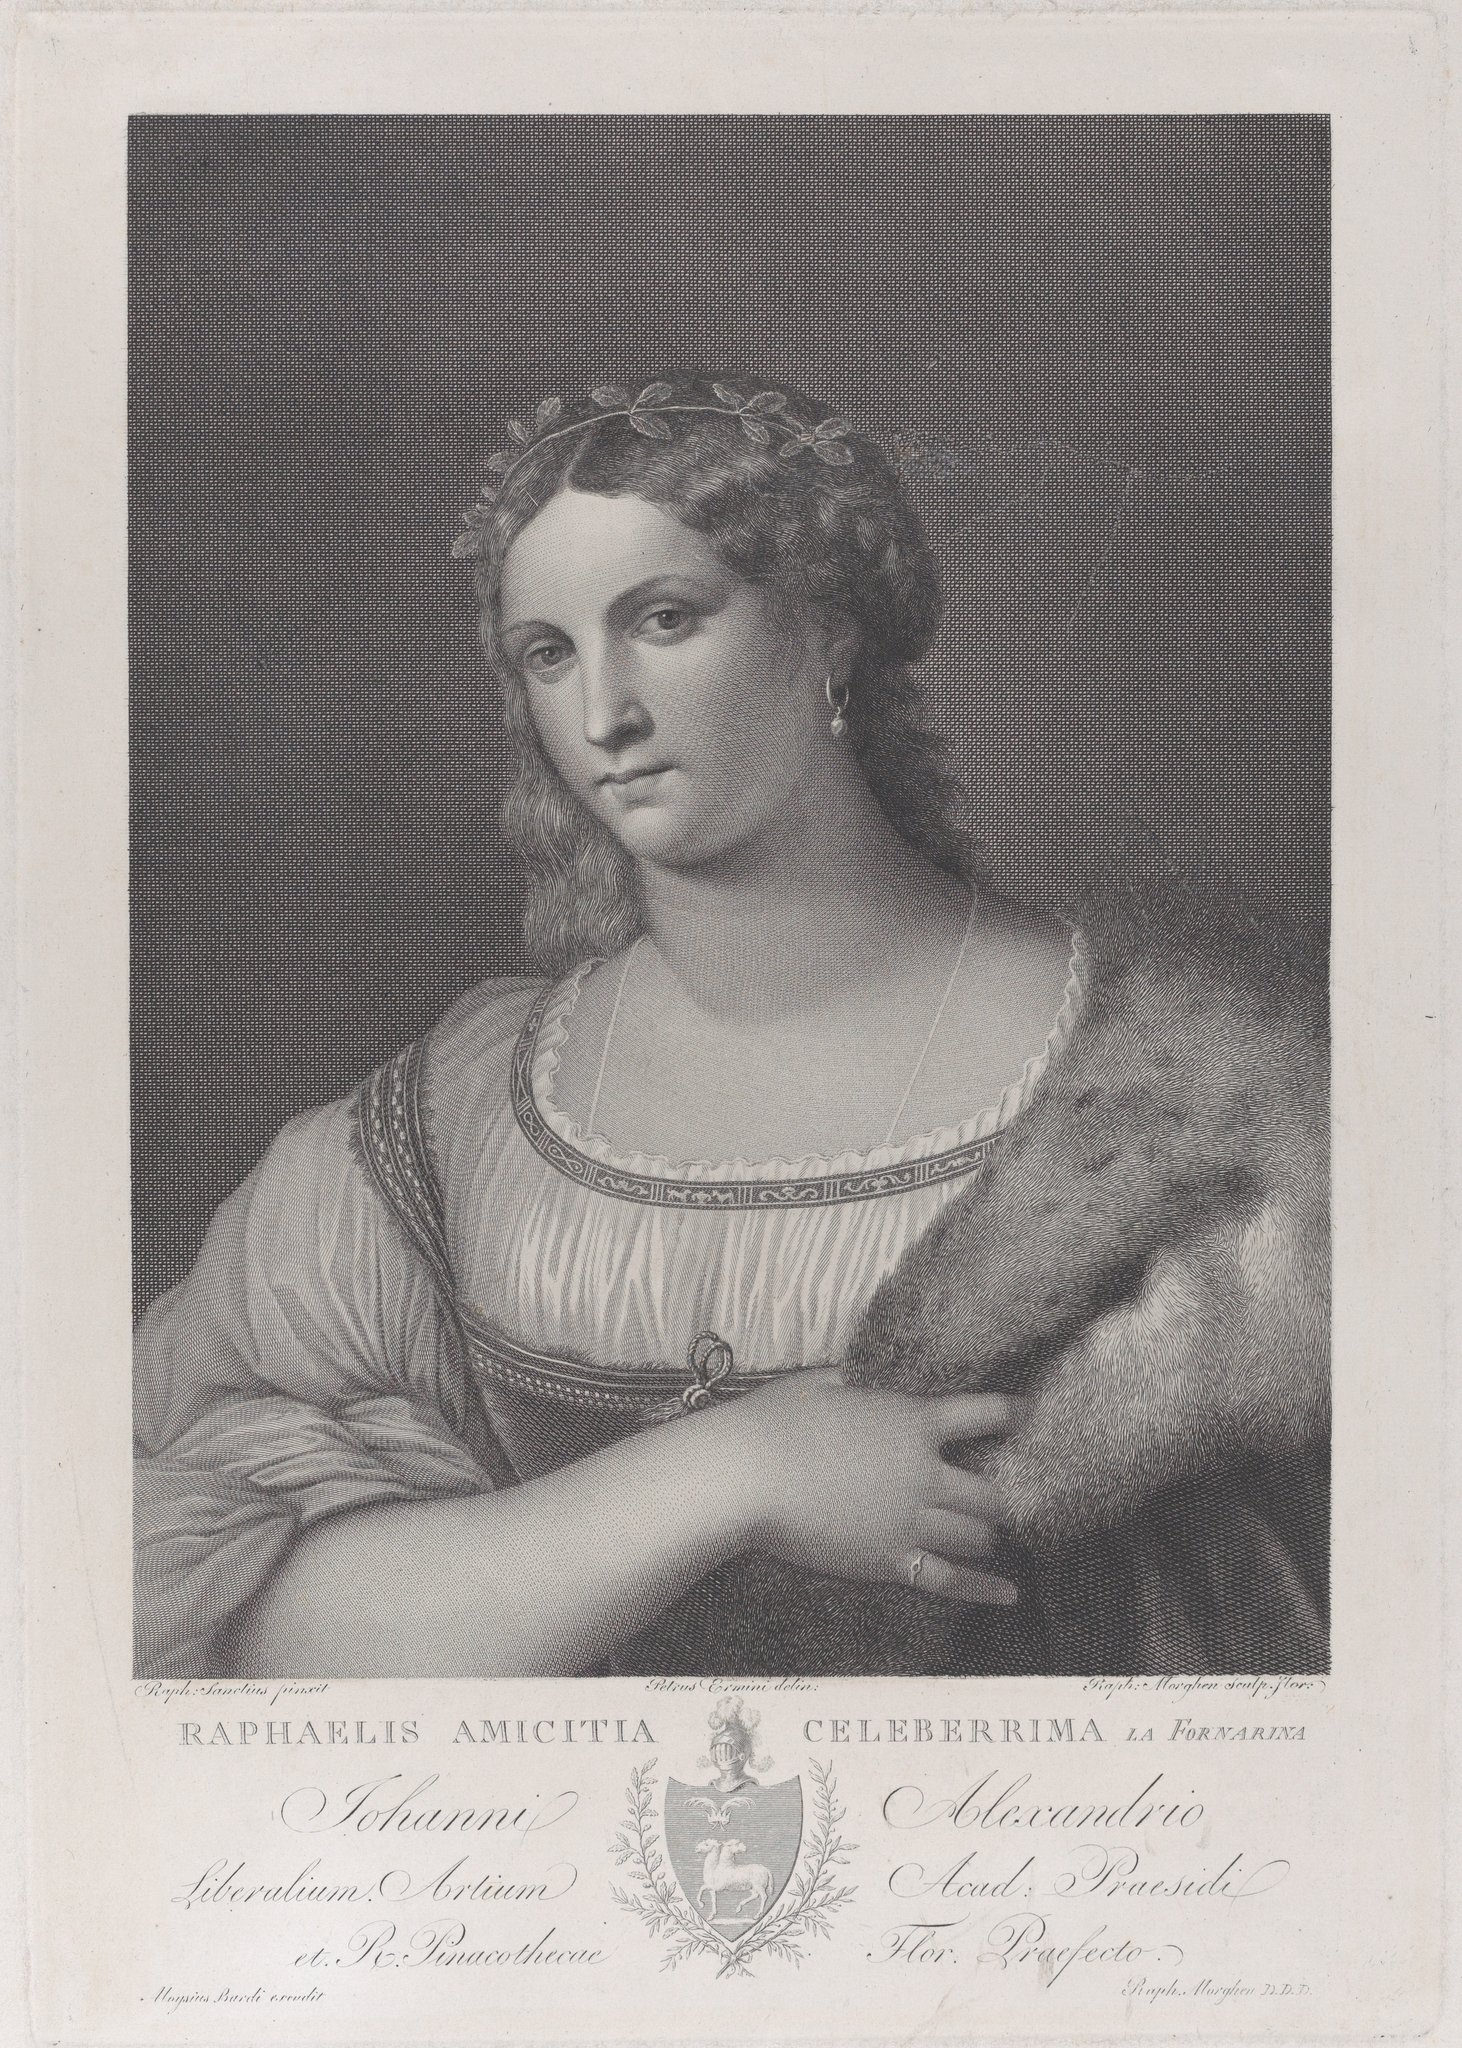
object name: print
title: La Fornarina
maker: raphael morghen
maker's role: artist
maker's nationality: italian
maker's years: 1758-1833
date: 1814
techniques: engraving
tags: women